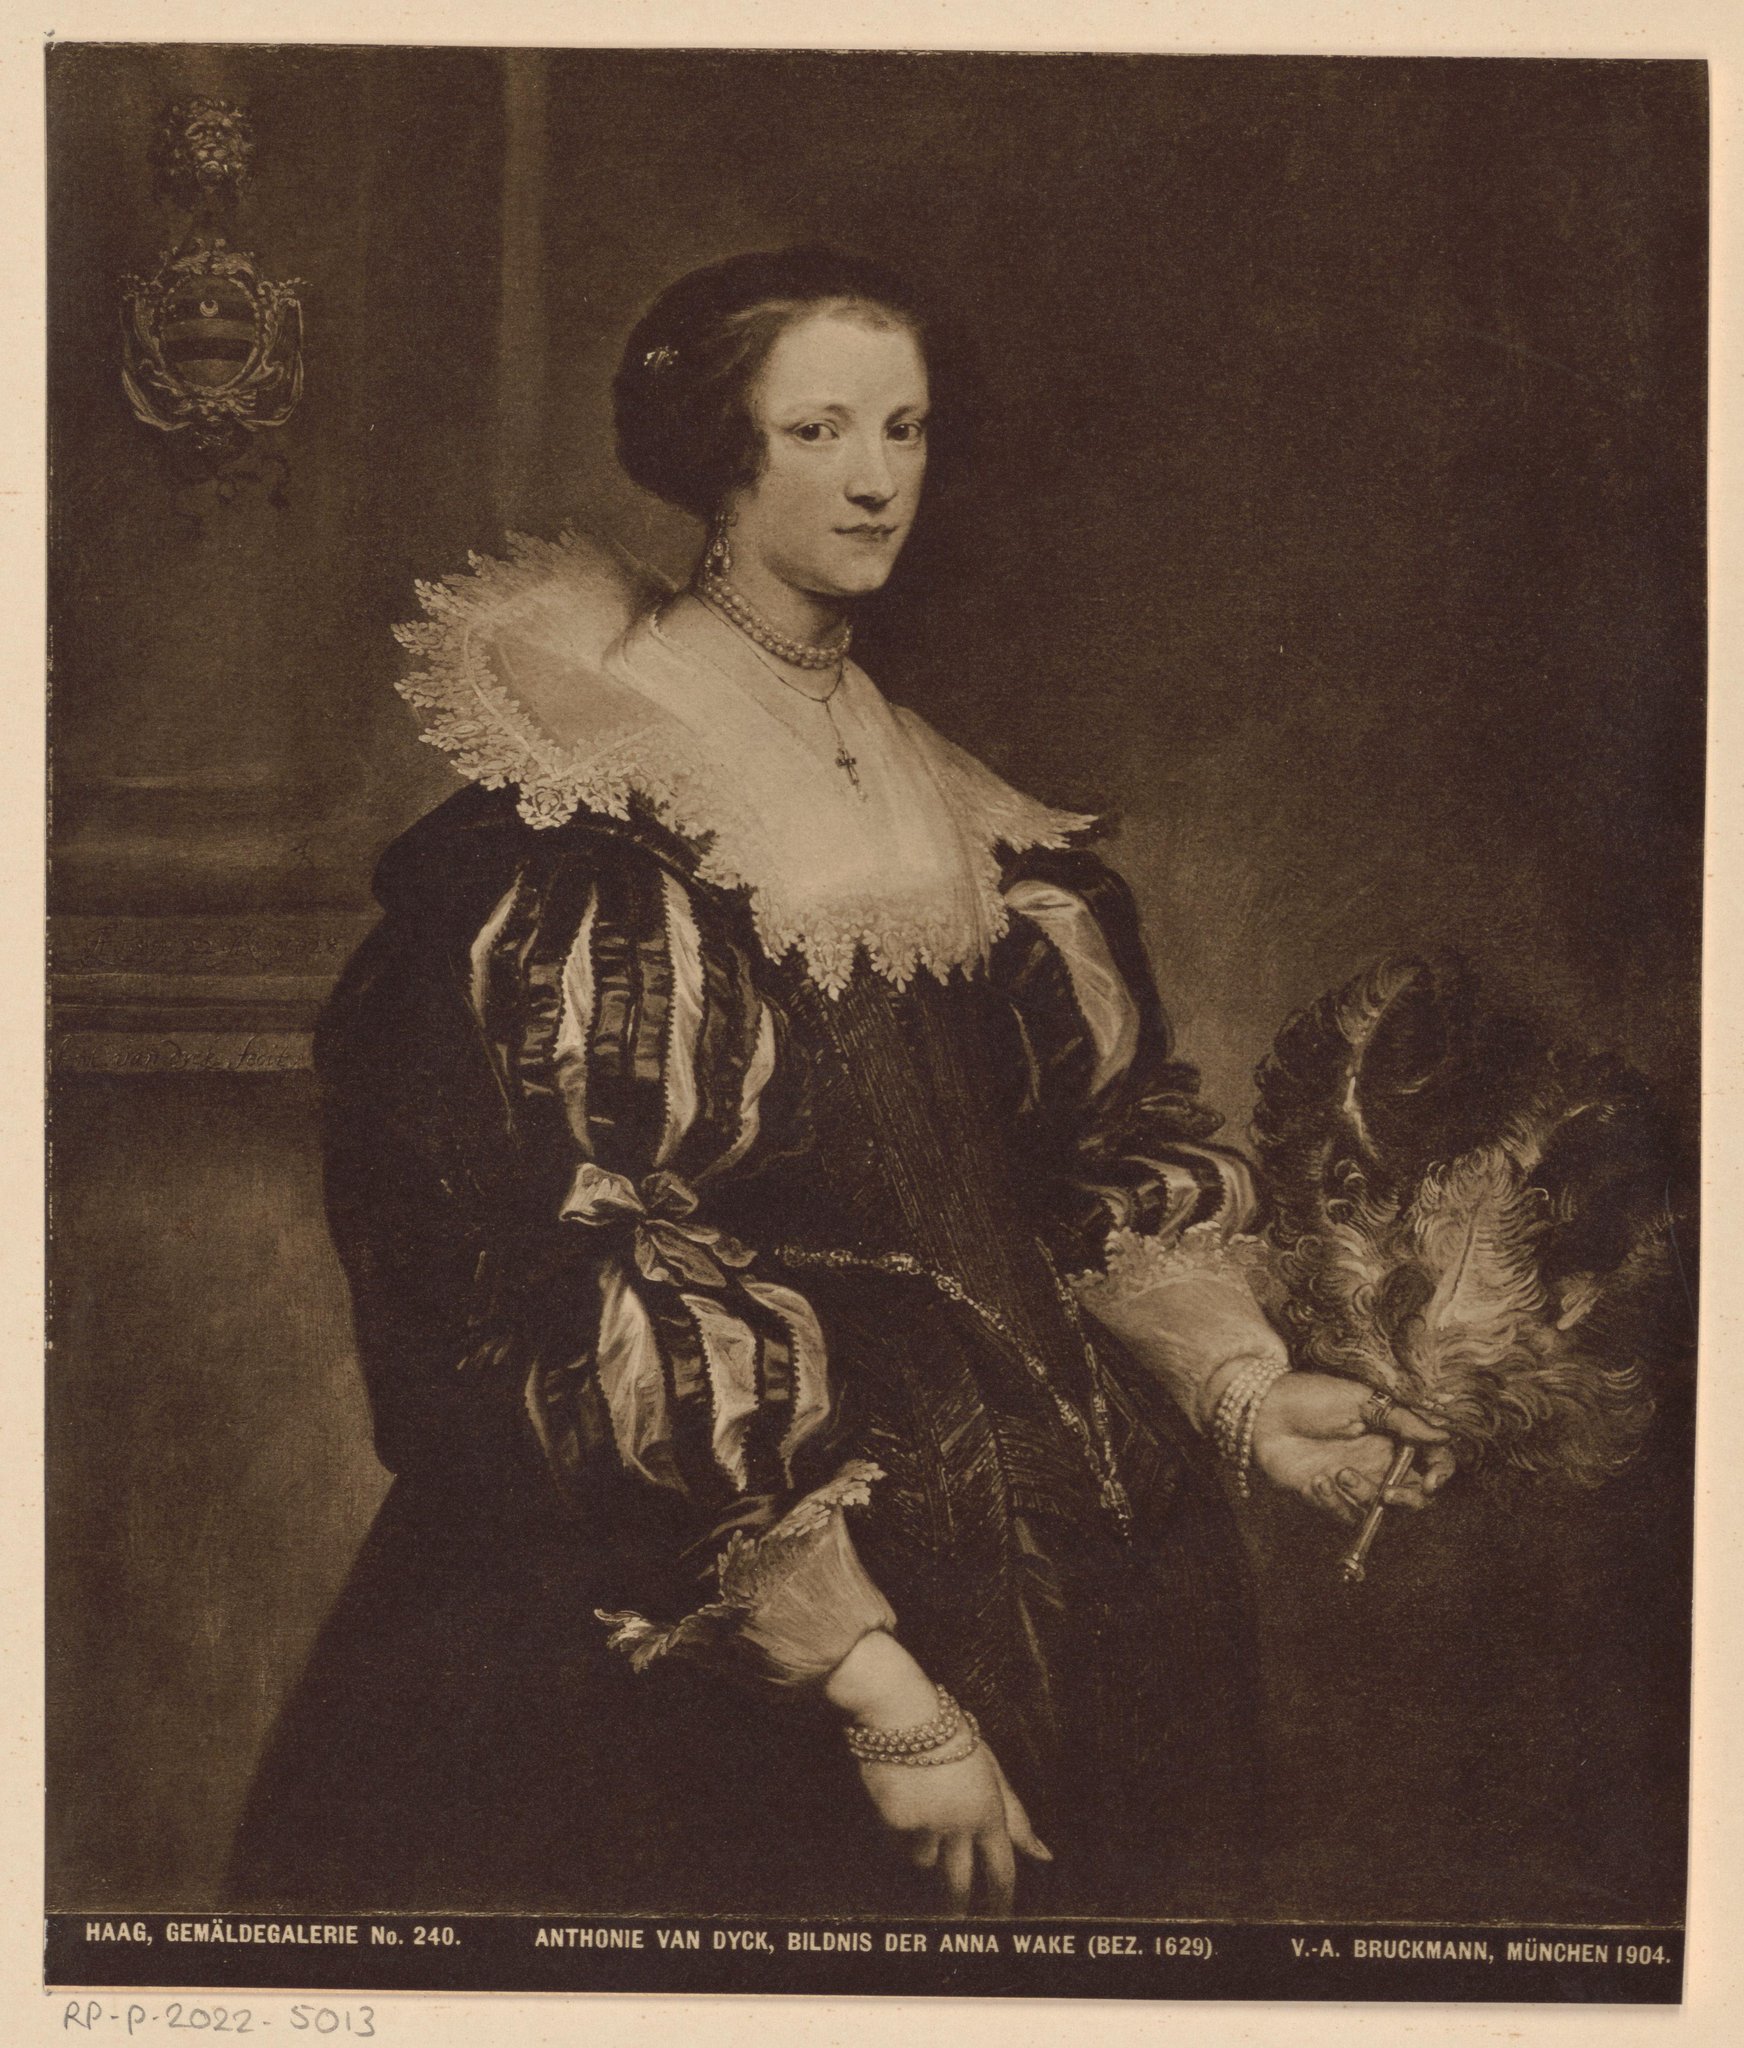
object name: photomechanical print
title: Portret van Anna Wake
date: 1904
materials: paper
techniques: photograph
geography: germany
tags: sheffield, antwerp, historical persons - bb - woman